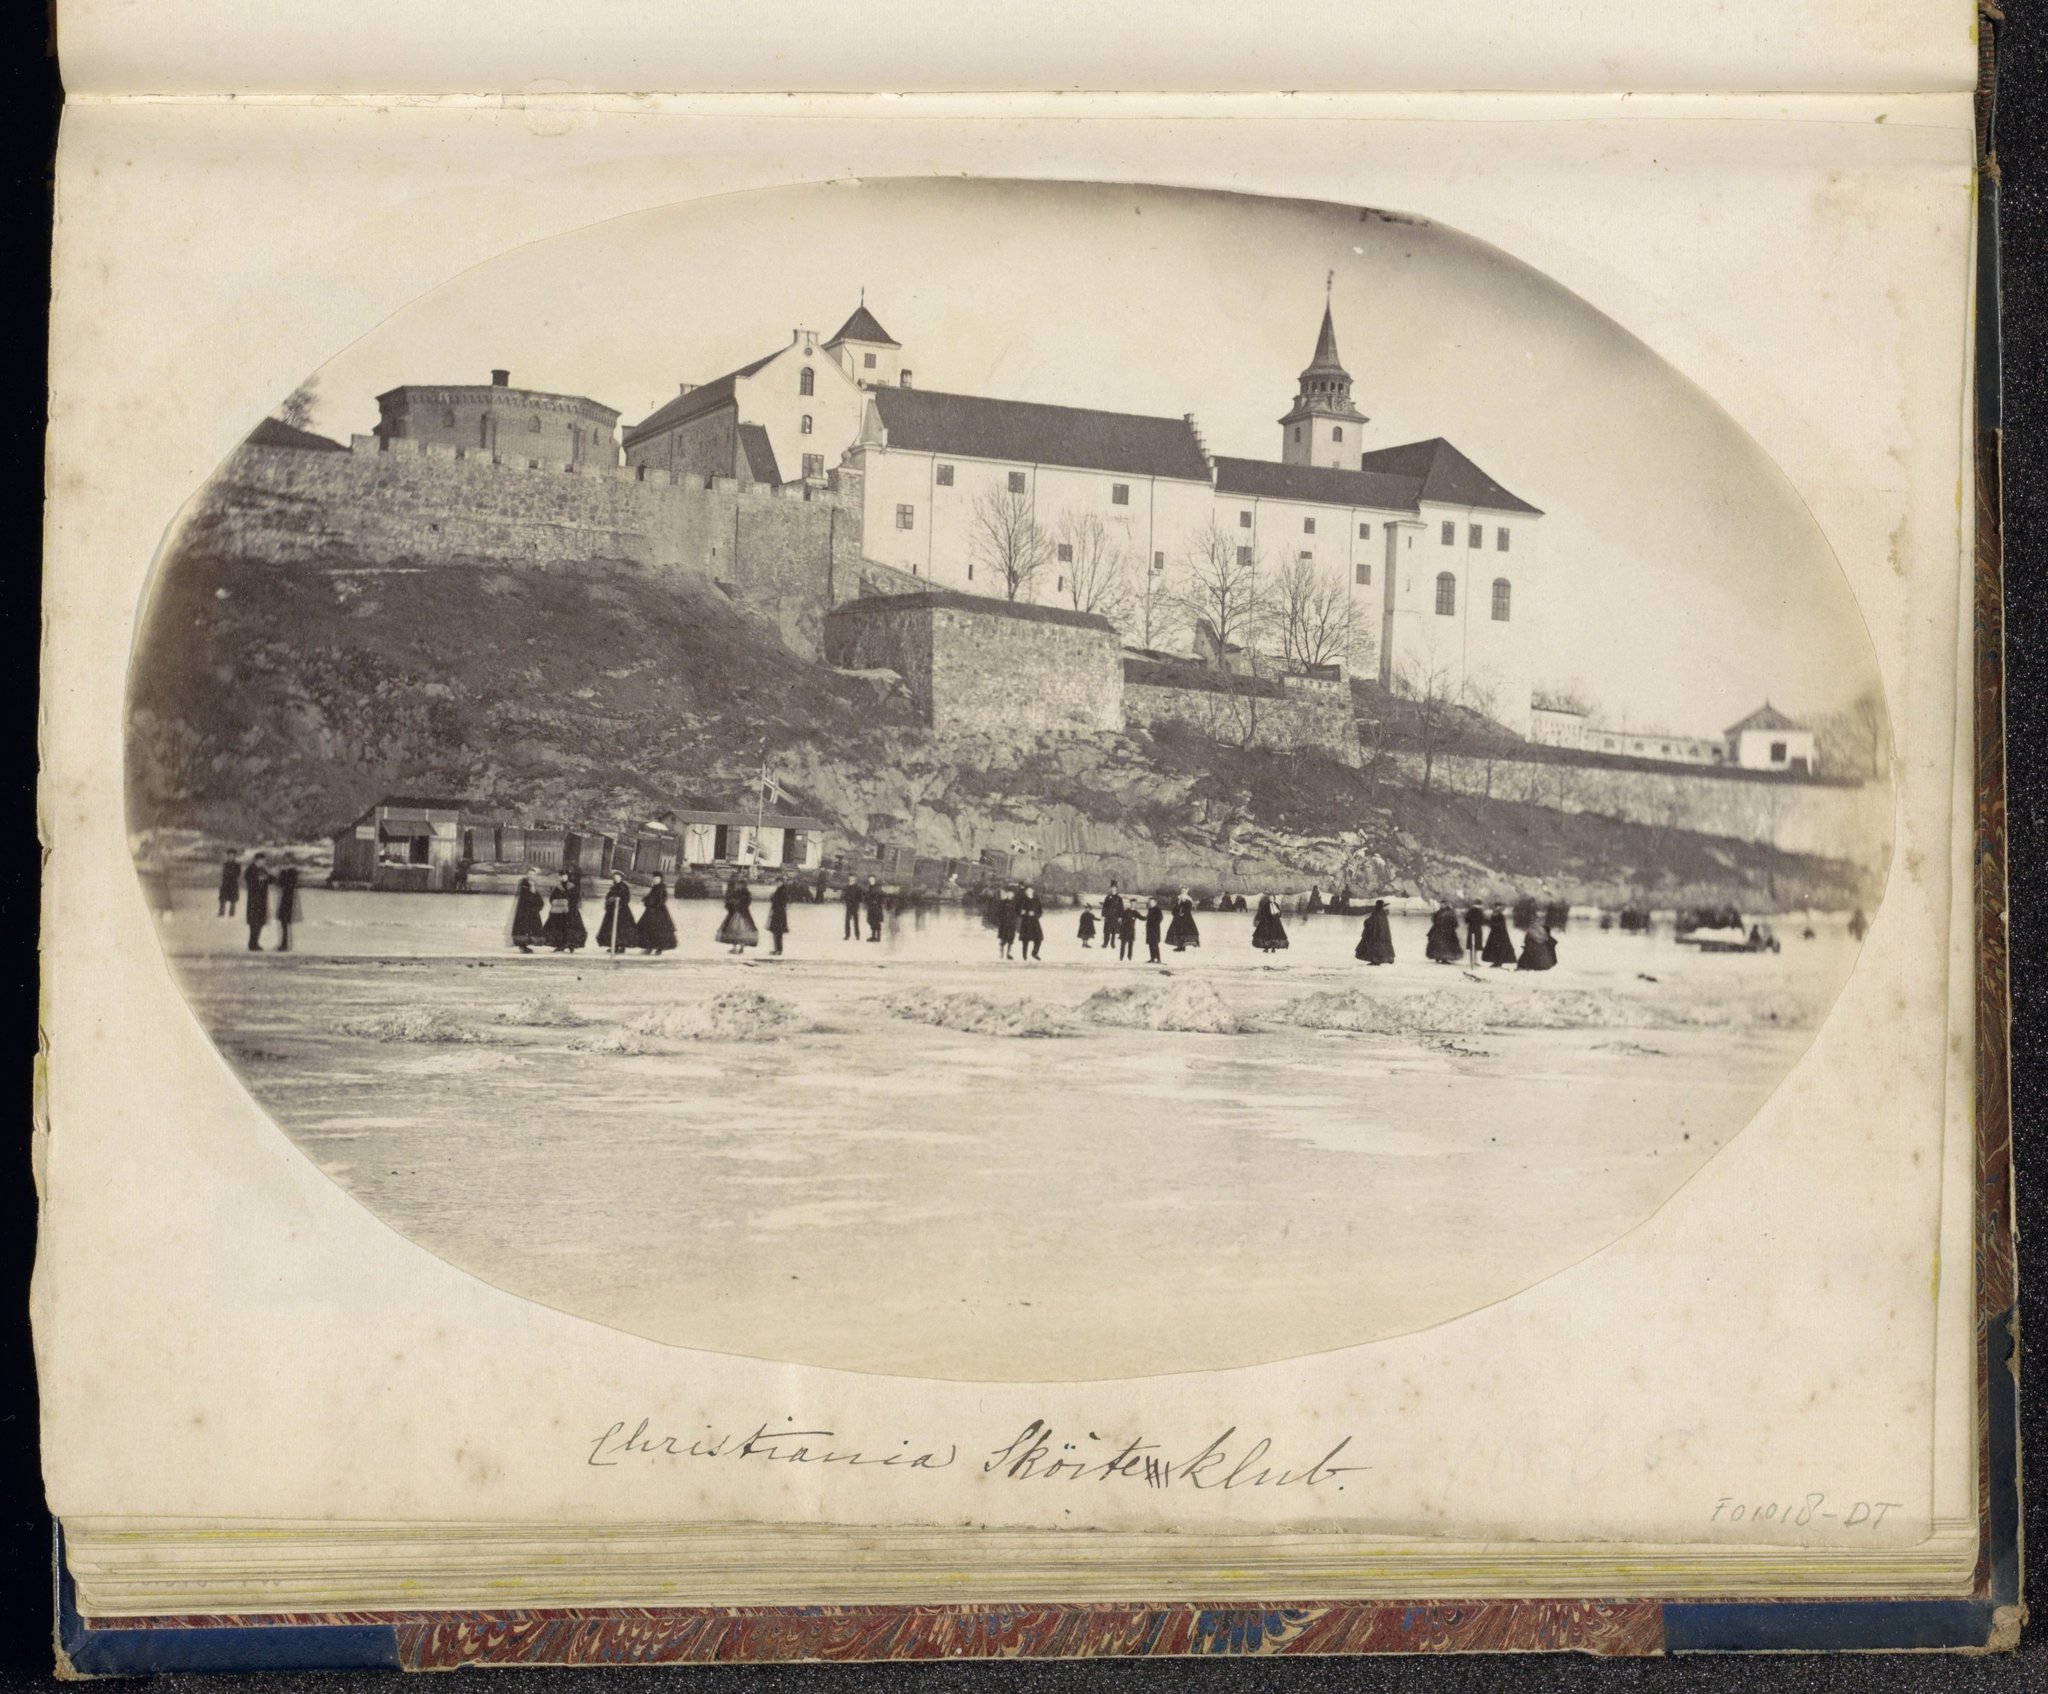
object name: photograph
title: Schaatsenrijders aan de voet van kasteel Akershus in Christiania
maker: Anonymous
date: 1865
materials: paper, photographic support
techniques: albumen print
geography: akershus fortress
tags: castle, skates (winter sports)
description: Onderdeel van Engels familiealbum met foto's van personen, reizen, cricket en kunstwerken.